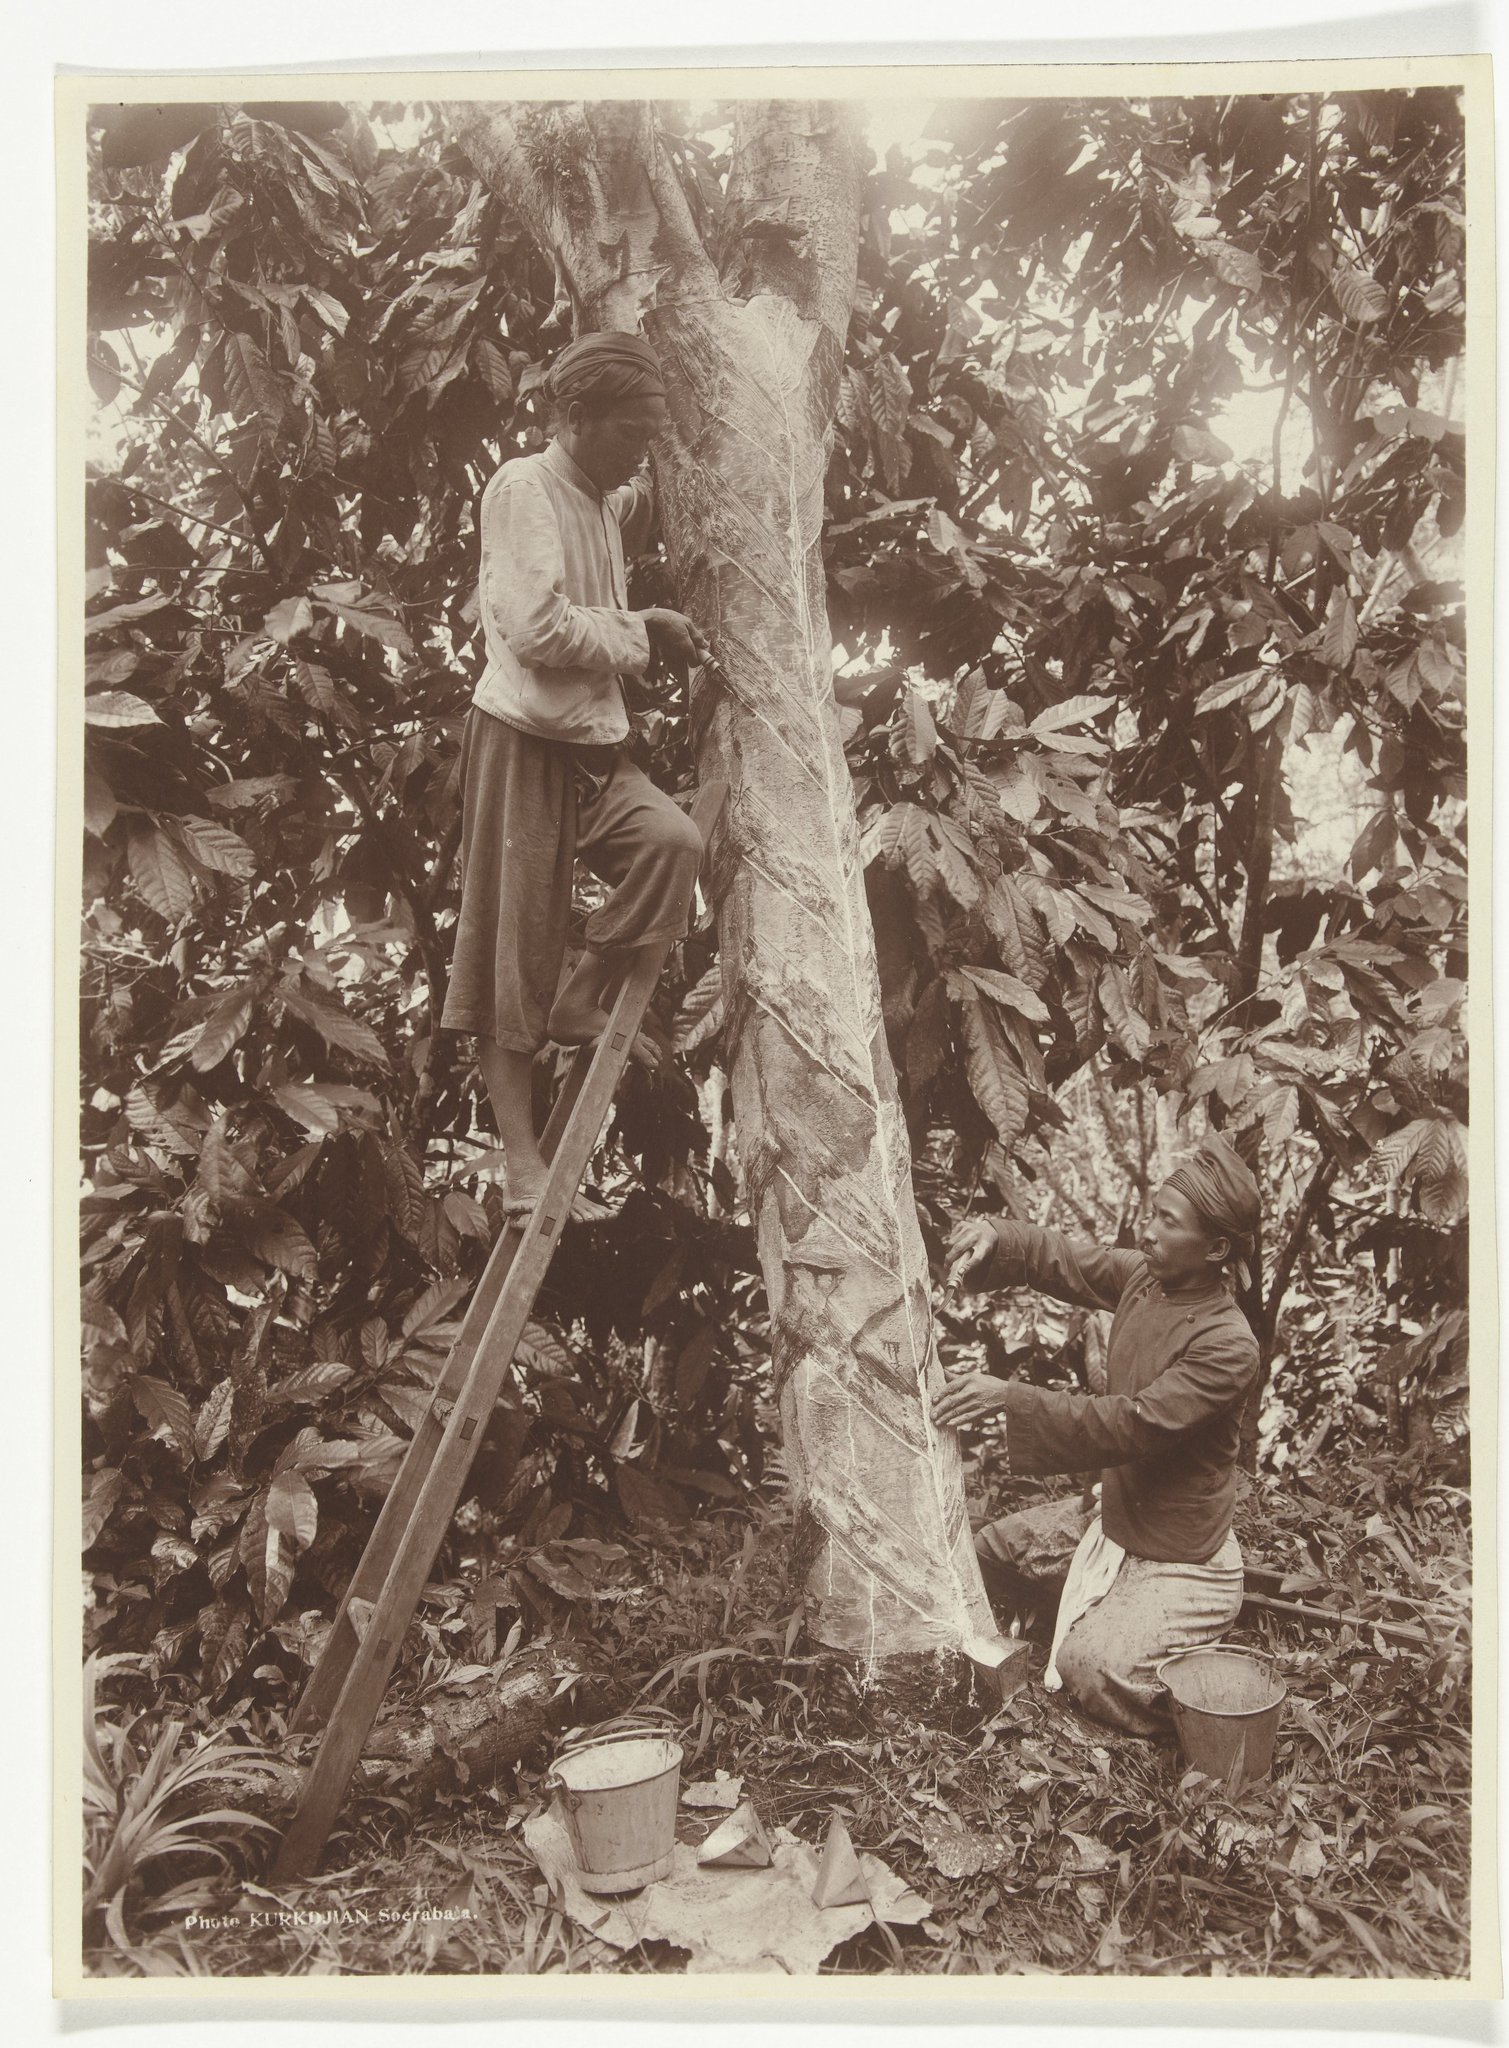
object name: photograph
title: Rubbertappers, voormalig Nederlands-Indië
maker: onnes kurkdjian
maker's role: fotograaf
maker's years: 1851-1903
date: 1908-1911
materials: paper, photographic support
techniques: gelatin silver print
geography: dutch east indies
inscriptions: name: ‘Photo Kurkdjian Soerabaia’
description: Mannen zijn bezig met het tappen van rubber, voormalig Nederlands-Indië